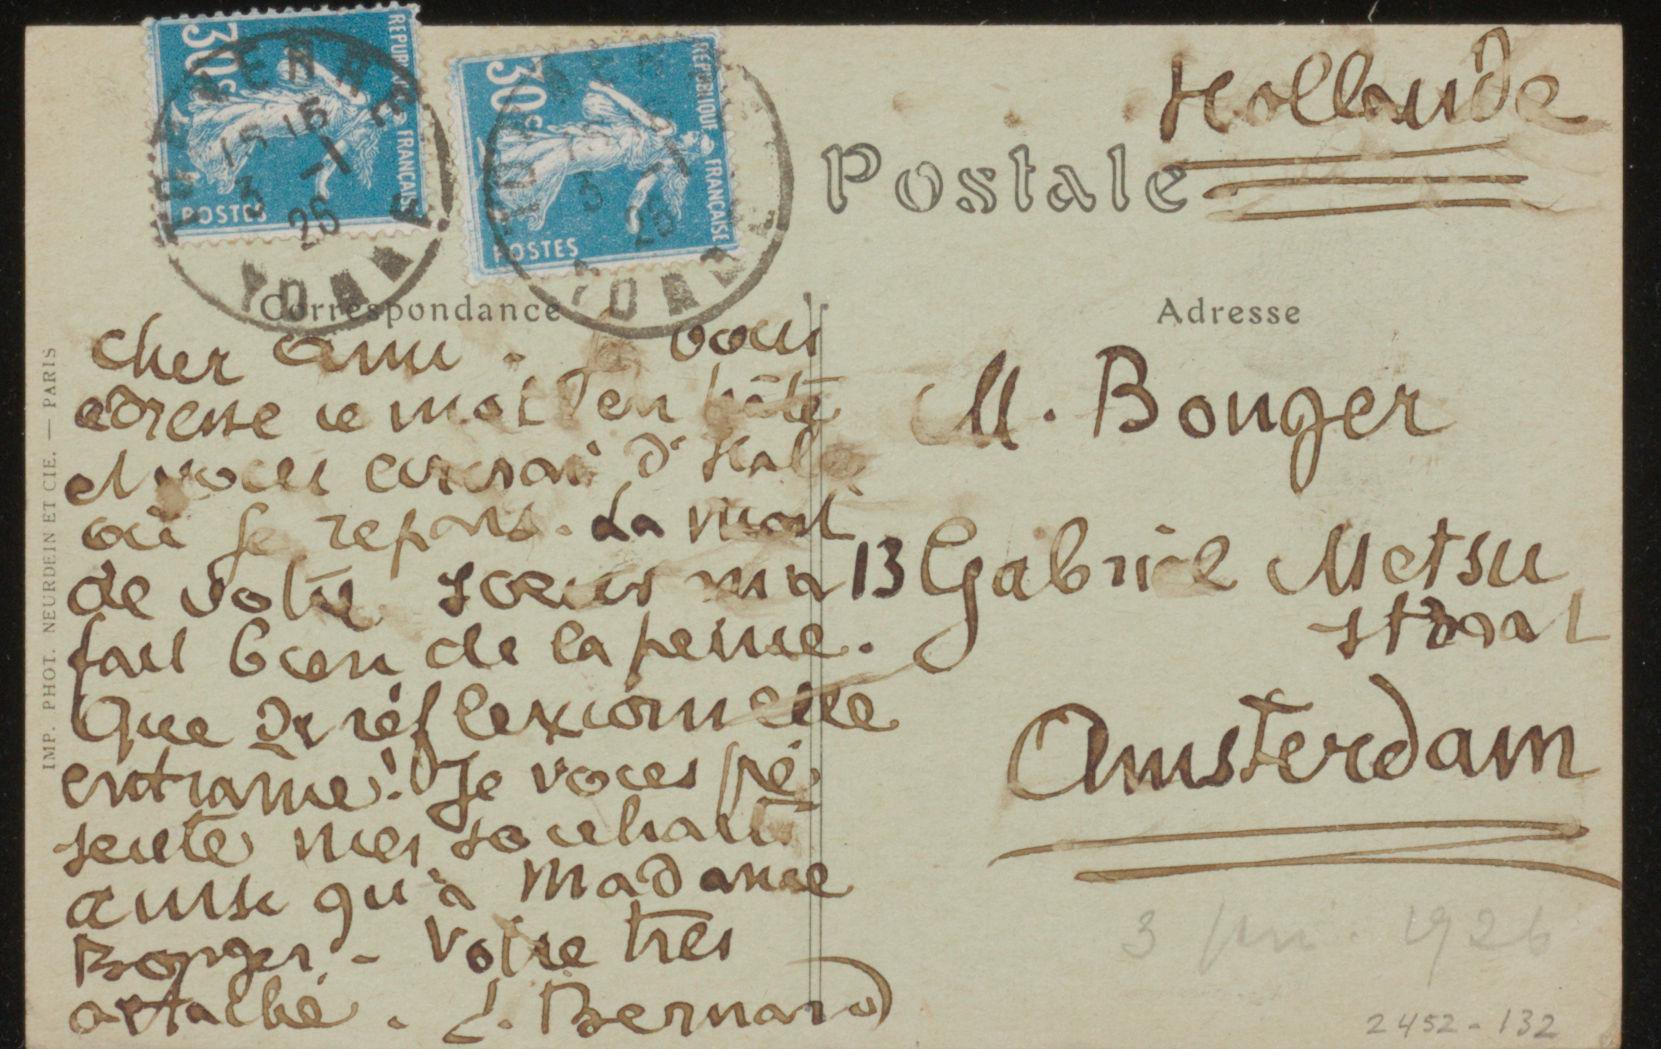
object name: ansichtkaart, prentbriefkaart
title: Prentbriefkaart aan Andries Bonger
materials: cardboard, ink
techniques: photograph, pen, writing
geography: paris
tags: andries bonger